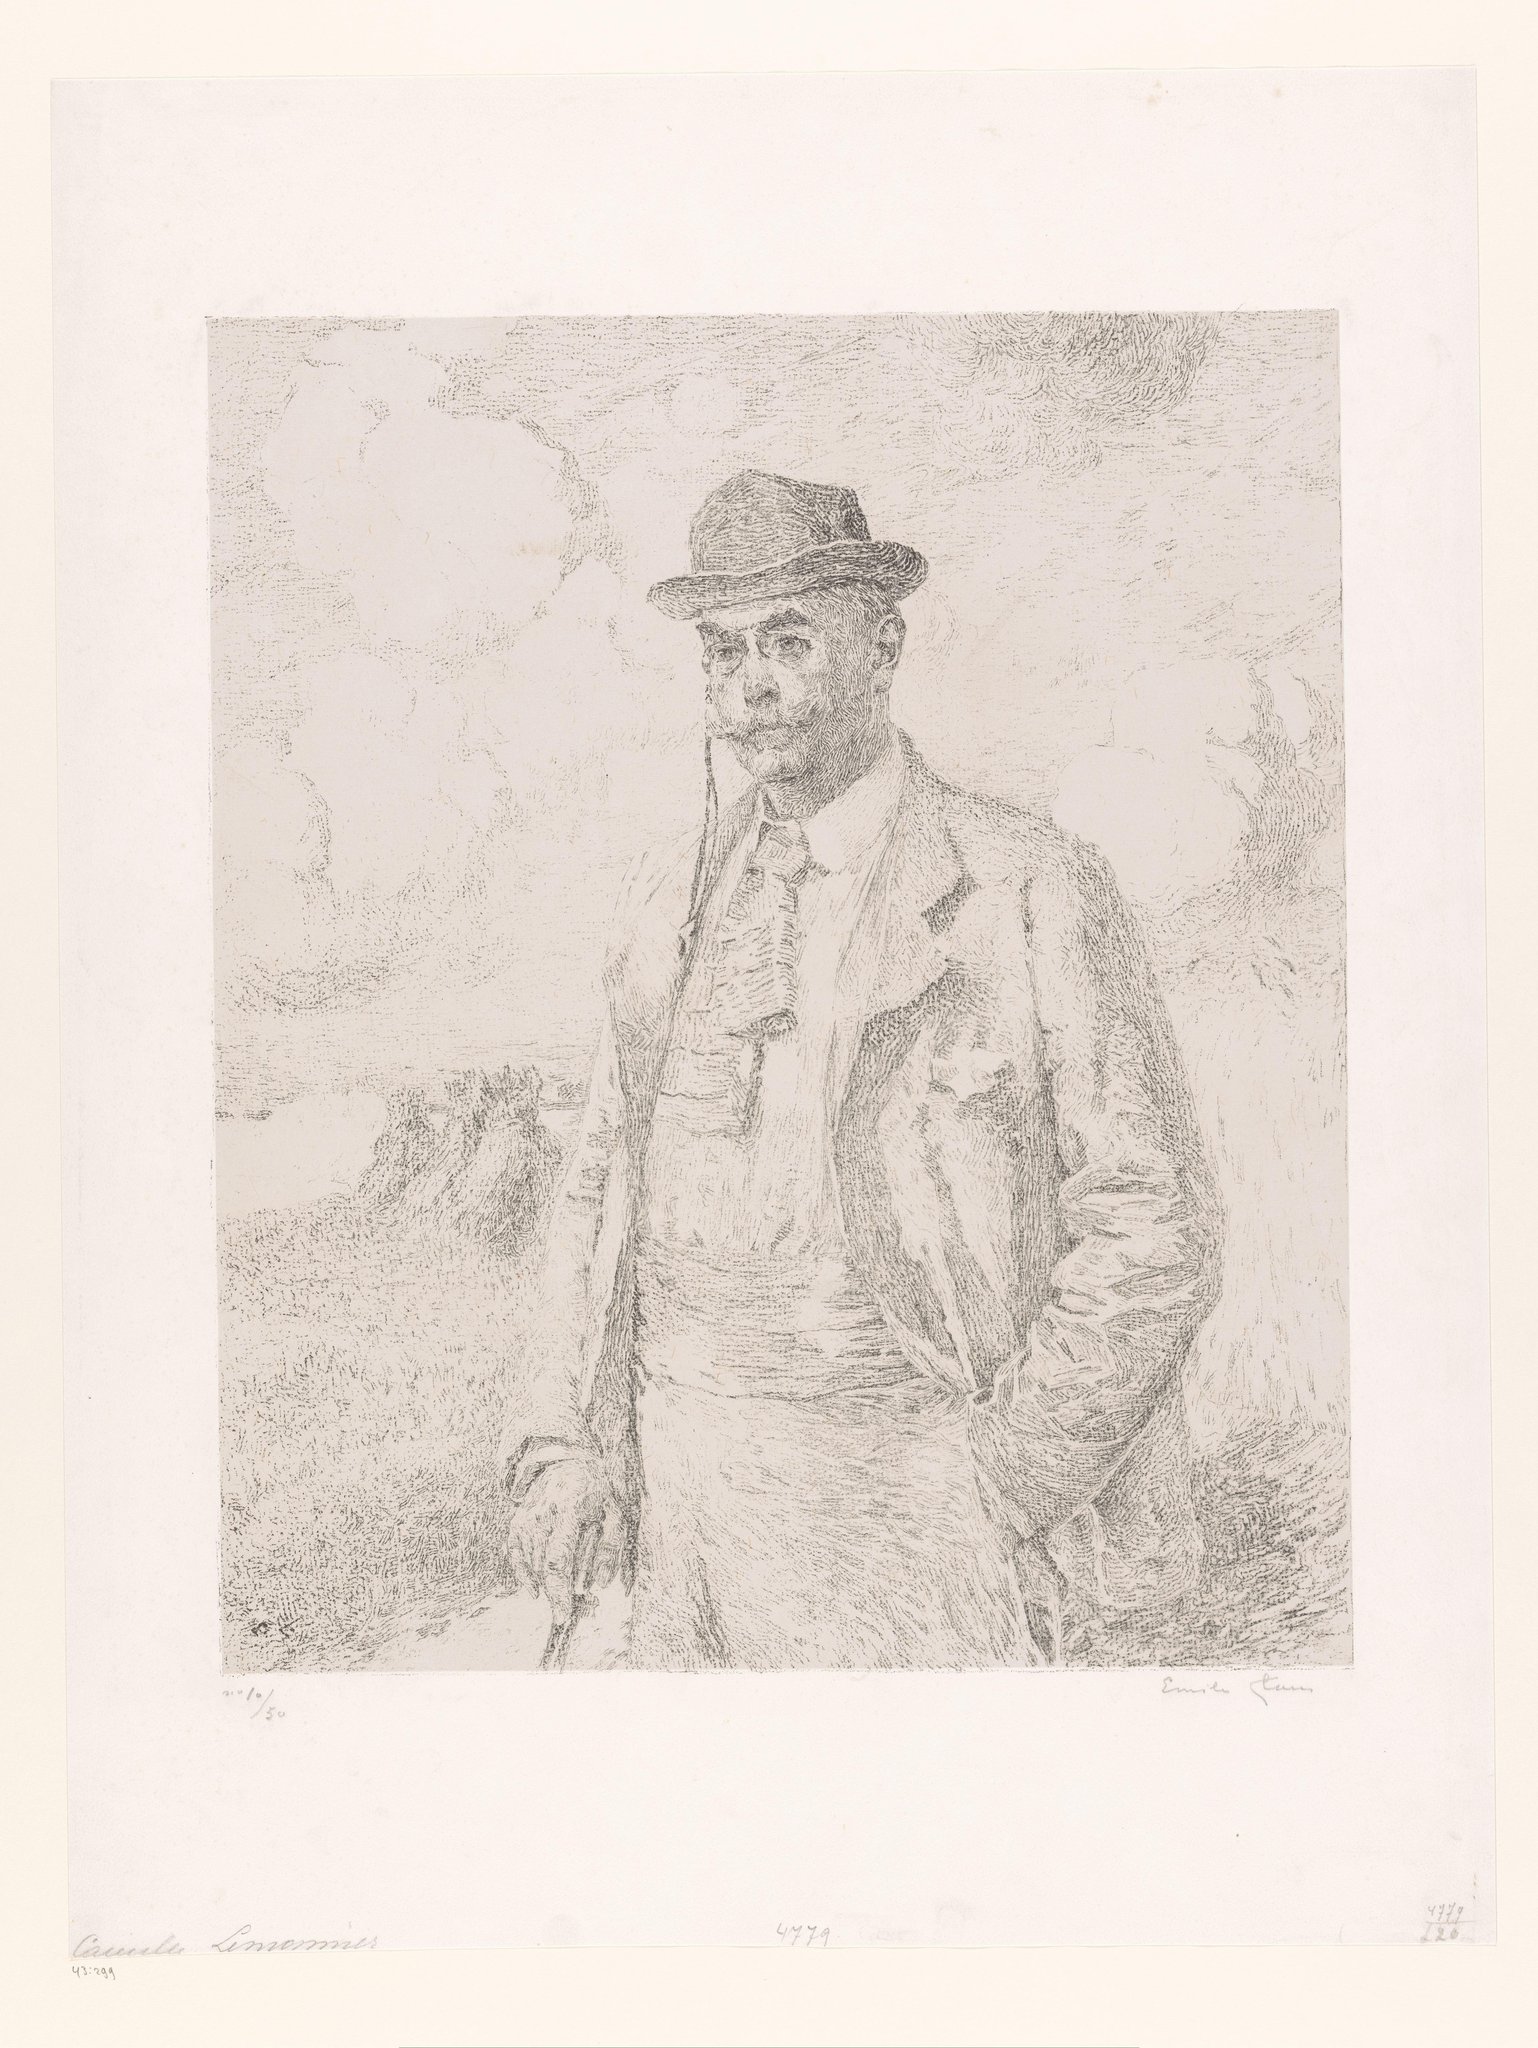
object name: print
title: Portret van Camille Lemonnier in een landschap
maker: emile claus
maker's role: print maker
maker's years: 1849-1924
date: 1903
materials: paper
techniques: lithograph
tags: camille lemonnier, eyeglasses, spectacles, head-gear, fashion designer, historical persons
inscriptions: collector's mark: Lugt 2228, collector's mark: Lugt 2760, inscription: ‘4779/20’